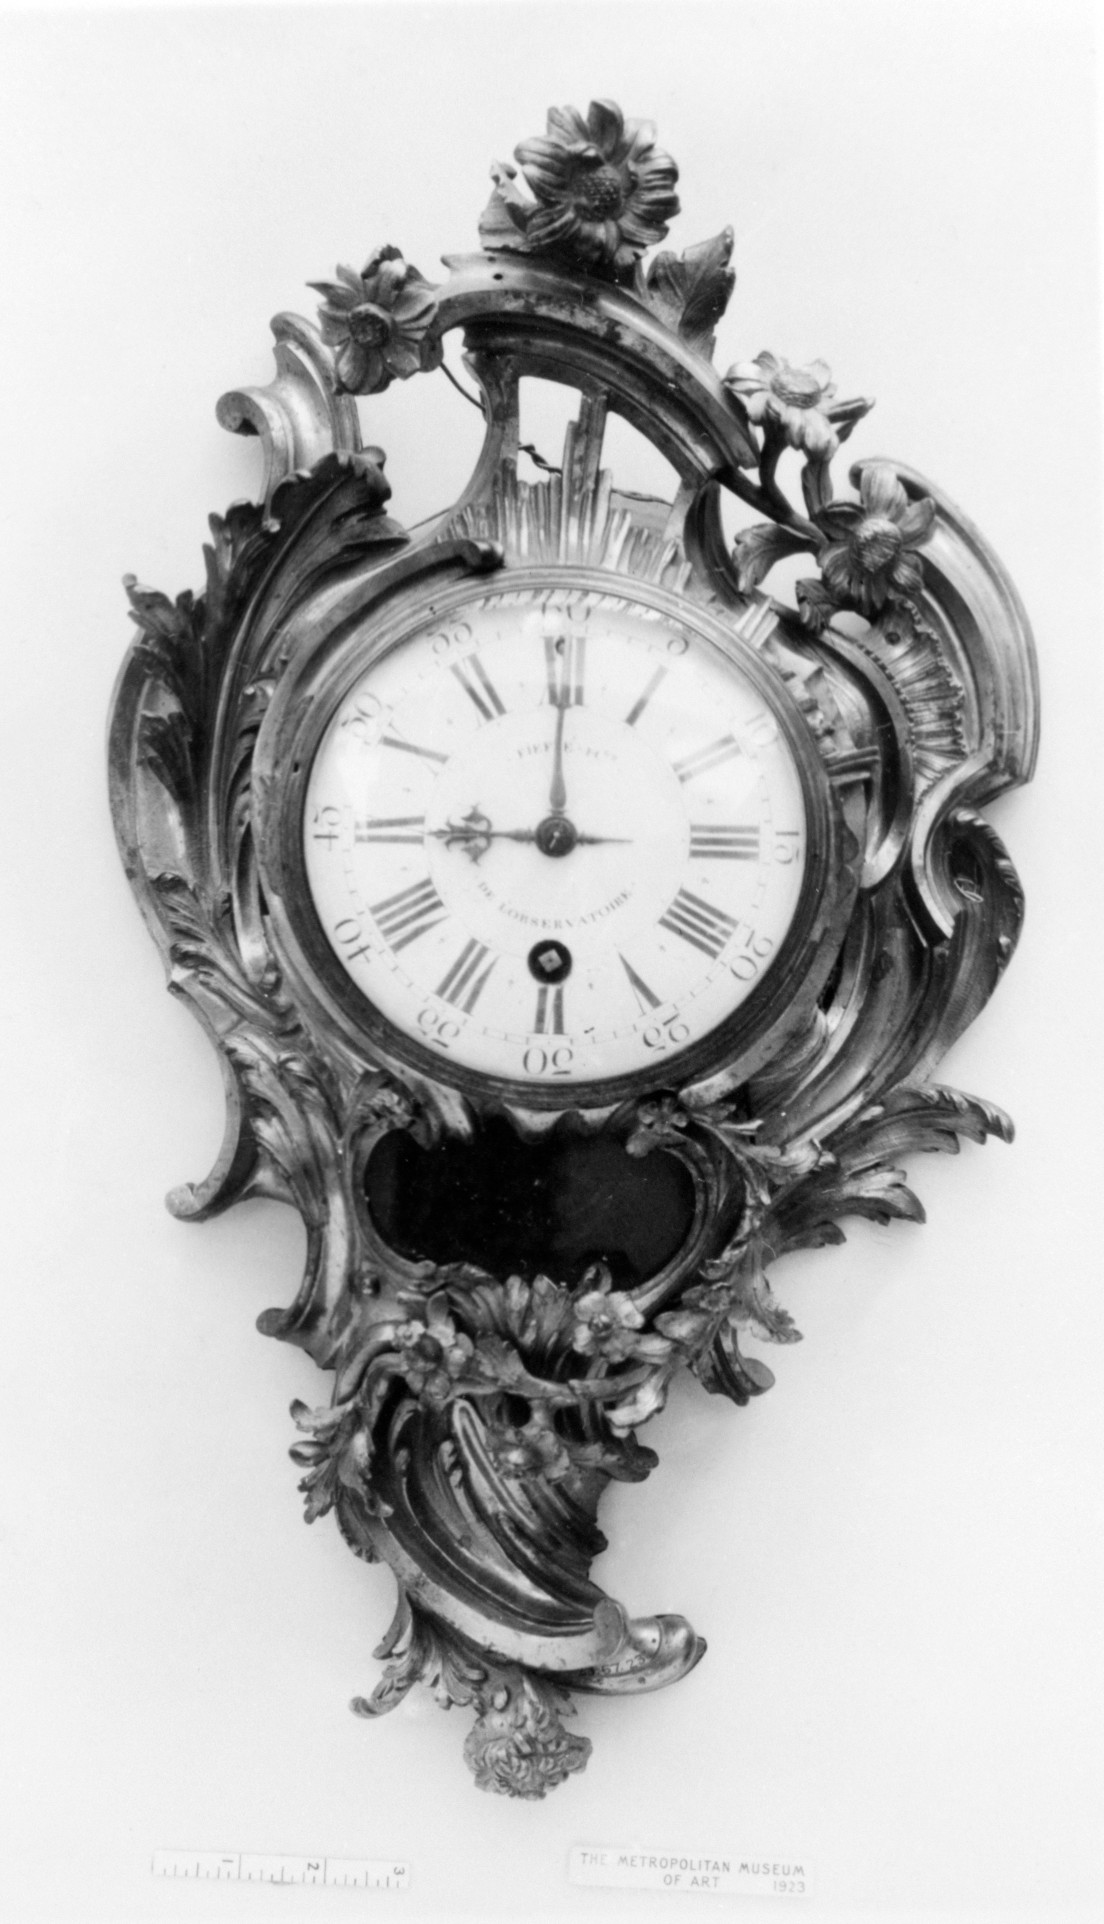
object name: wall clock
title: Wall clock (cartel)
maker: jean-jacques fieffé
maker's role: maker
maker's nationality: french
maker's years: 1700-1770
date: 1745-1749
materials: bronze, enamel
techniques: gilding